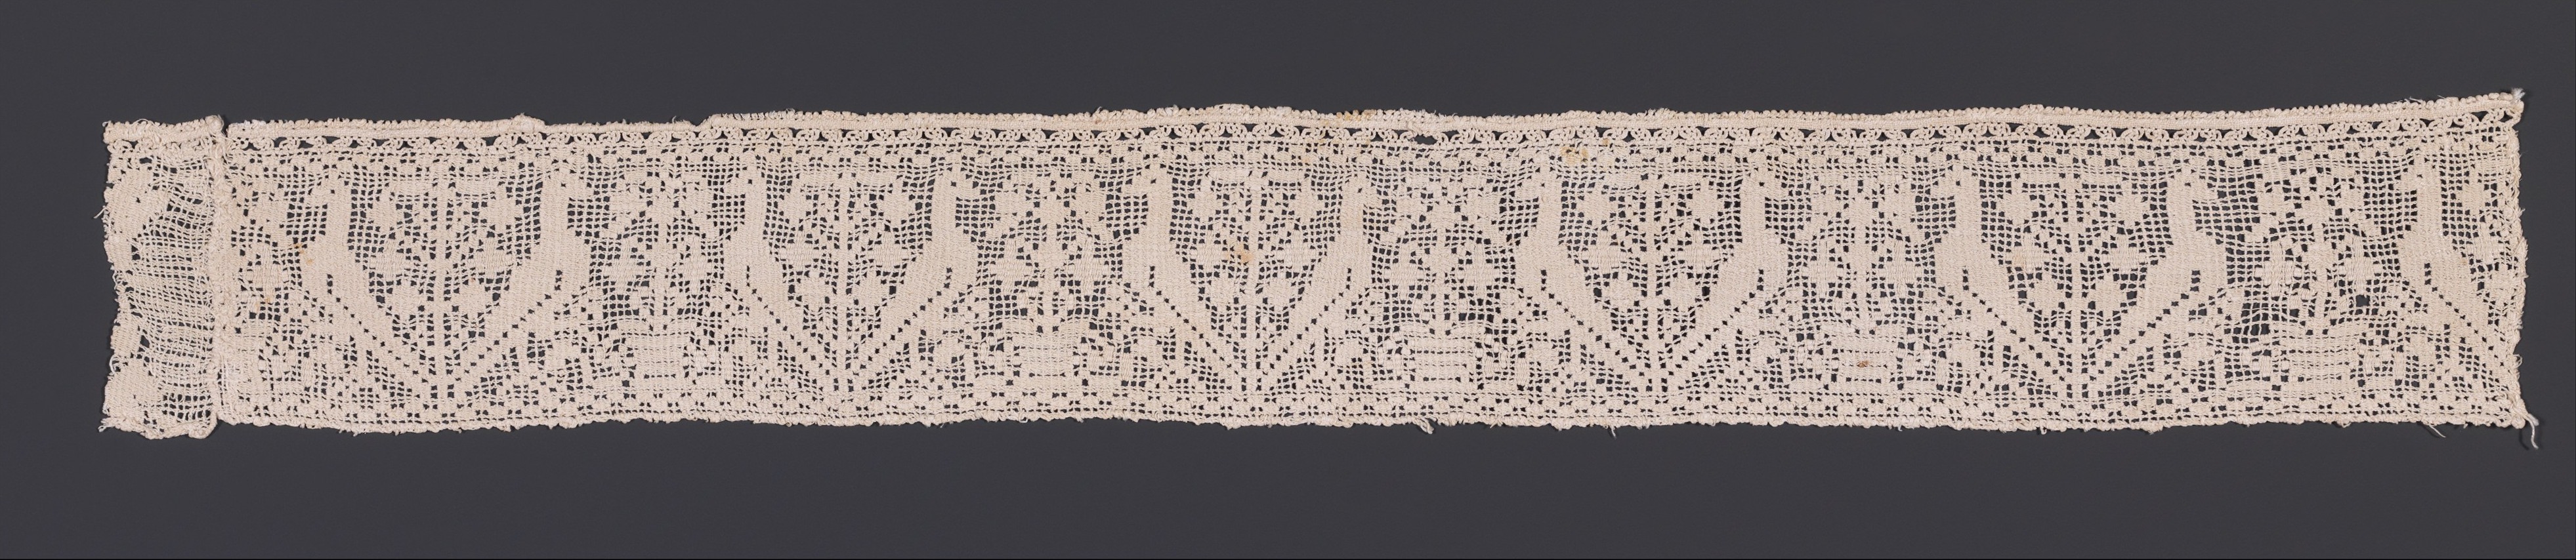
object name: band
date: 1501-1600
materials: silk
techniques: embroidery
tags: birds